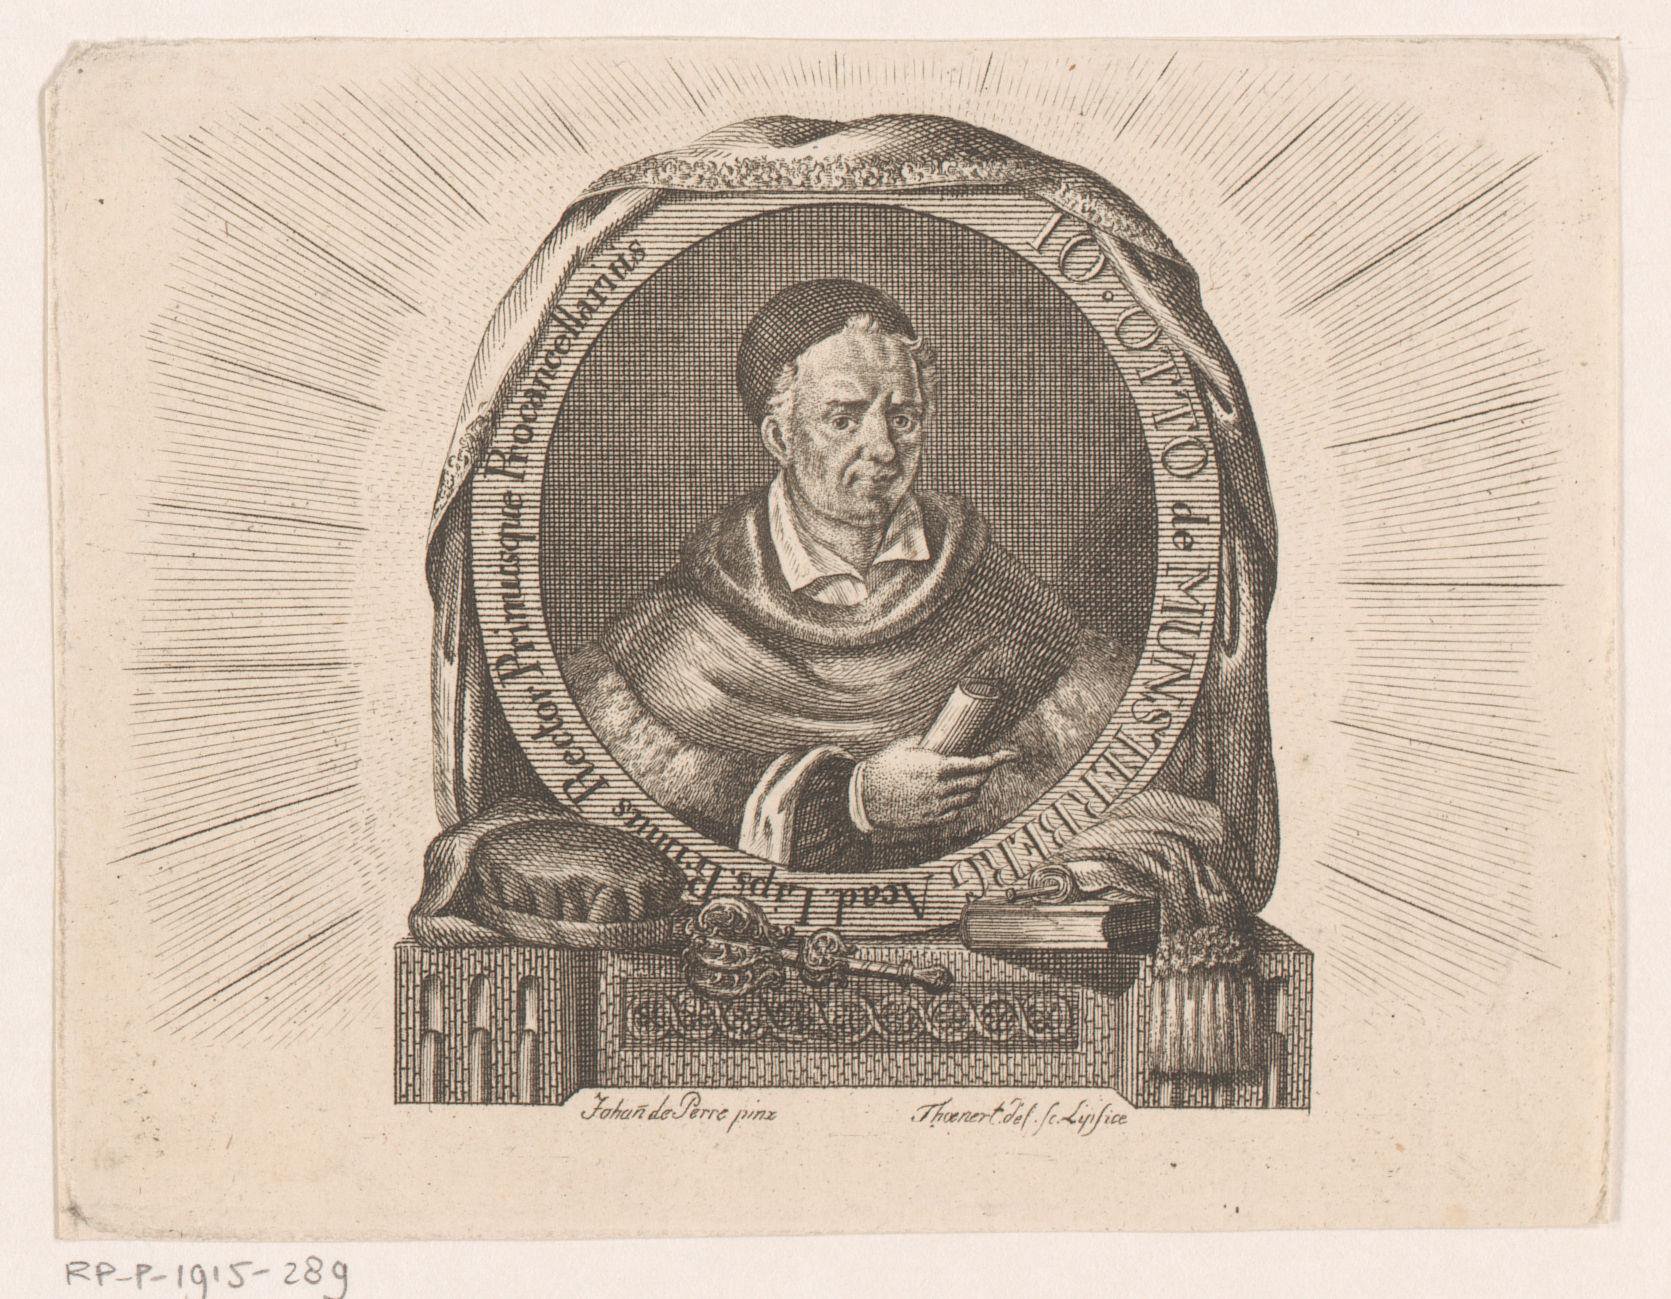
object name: print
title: Portret van Johannes Otto von Münsterberg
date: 1764-1814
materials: paper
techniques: engraving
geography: leipzig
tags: poland, historical persons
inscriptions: collector's mark: Lugt 2228